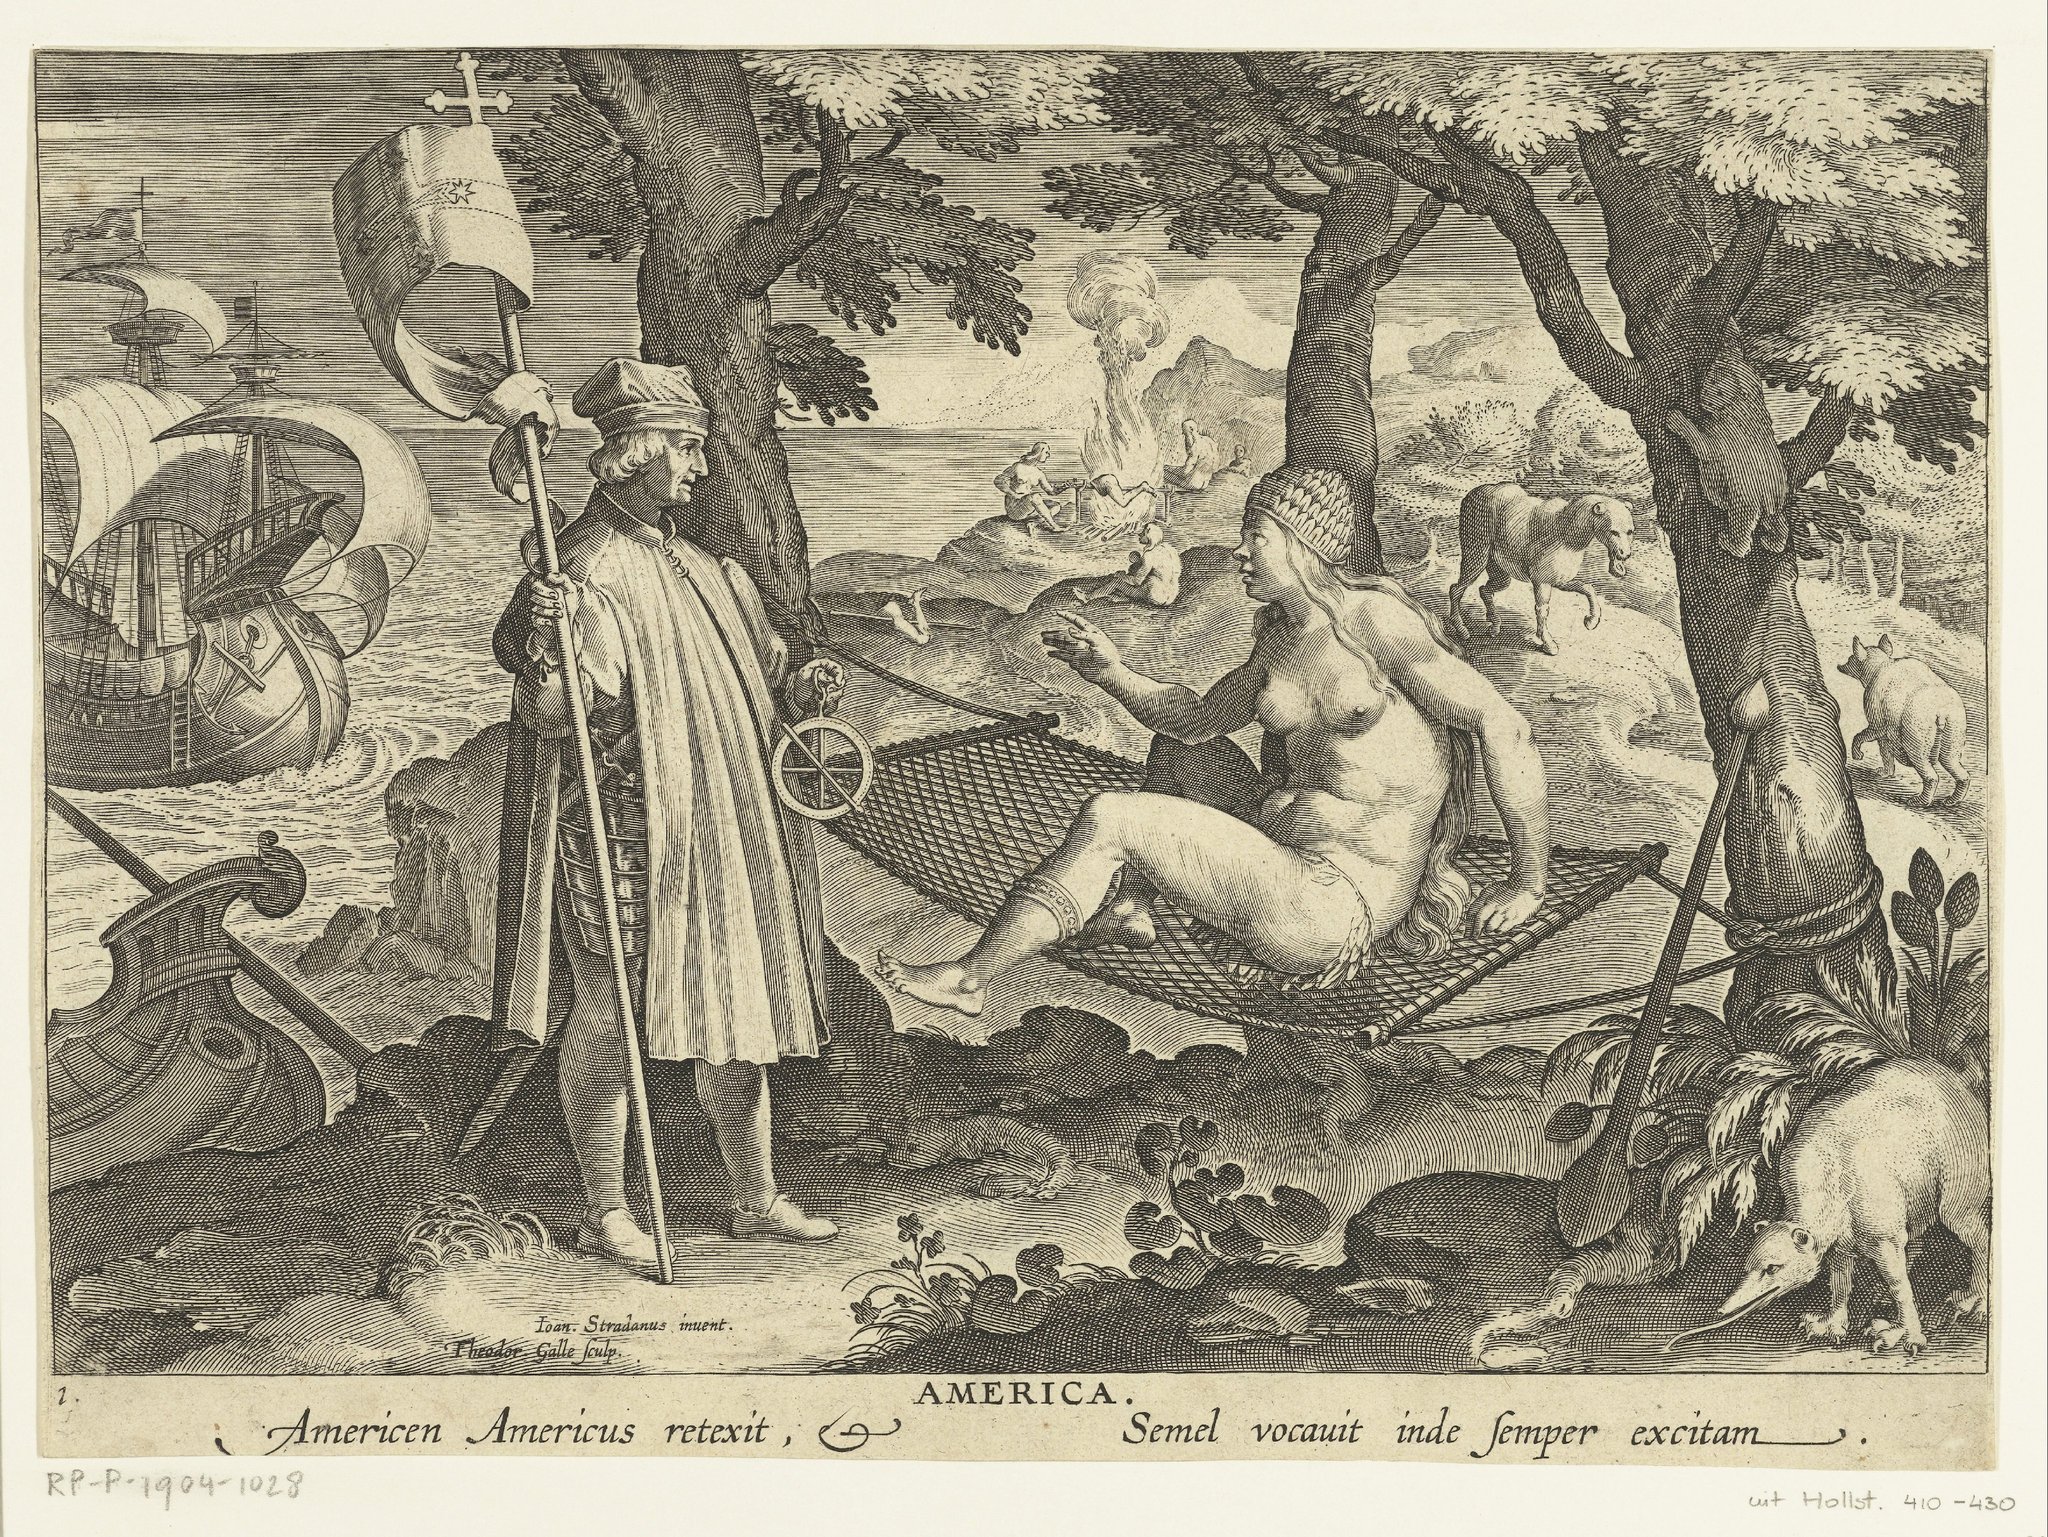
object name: print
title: Amerigo Vespucci zet voet aan wal in Amerika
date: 1589-1593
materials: paper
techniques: engraving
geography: antwerp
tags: sevilla, america represented allegorically; 'america' (ripa), indigenous peoples of south america, exploration, expedition, voyage of discovery, cannibalism, invention, discovery ~ science and technology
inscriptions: collector's mark: Lugt 2228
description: Amerigo Vespucci zet voet aan wal in Amerika. In zijn linkerhand een astrolabium, in zijn rechter een vaandel met het Zuiderkruis-sterrenbeeld. De personificatie van Amerika, een naakte vrouw met verentooi, klimt uit haar hangmat om hem te groeten. Op de achtergrond zijn de vermeende kannibalistische gewoontes van de lokale bevolking, mogelijk Tupinamba, en enkele inheemse dieren afgebeeld. De prent heeft een Latijns onderschrift en maakt deel uit van een negentiendelige serie over nieuwe uitvindingen en ontdekkingen.